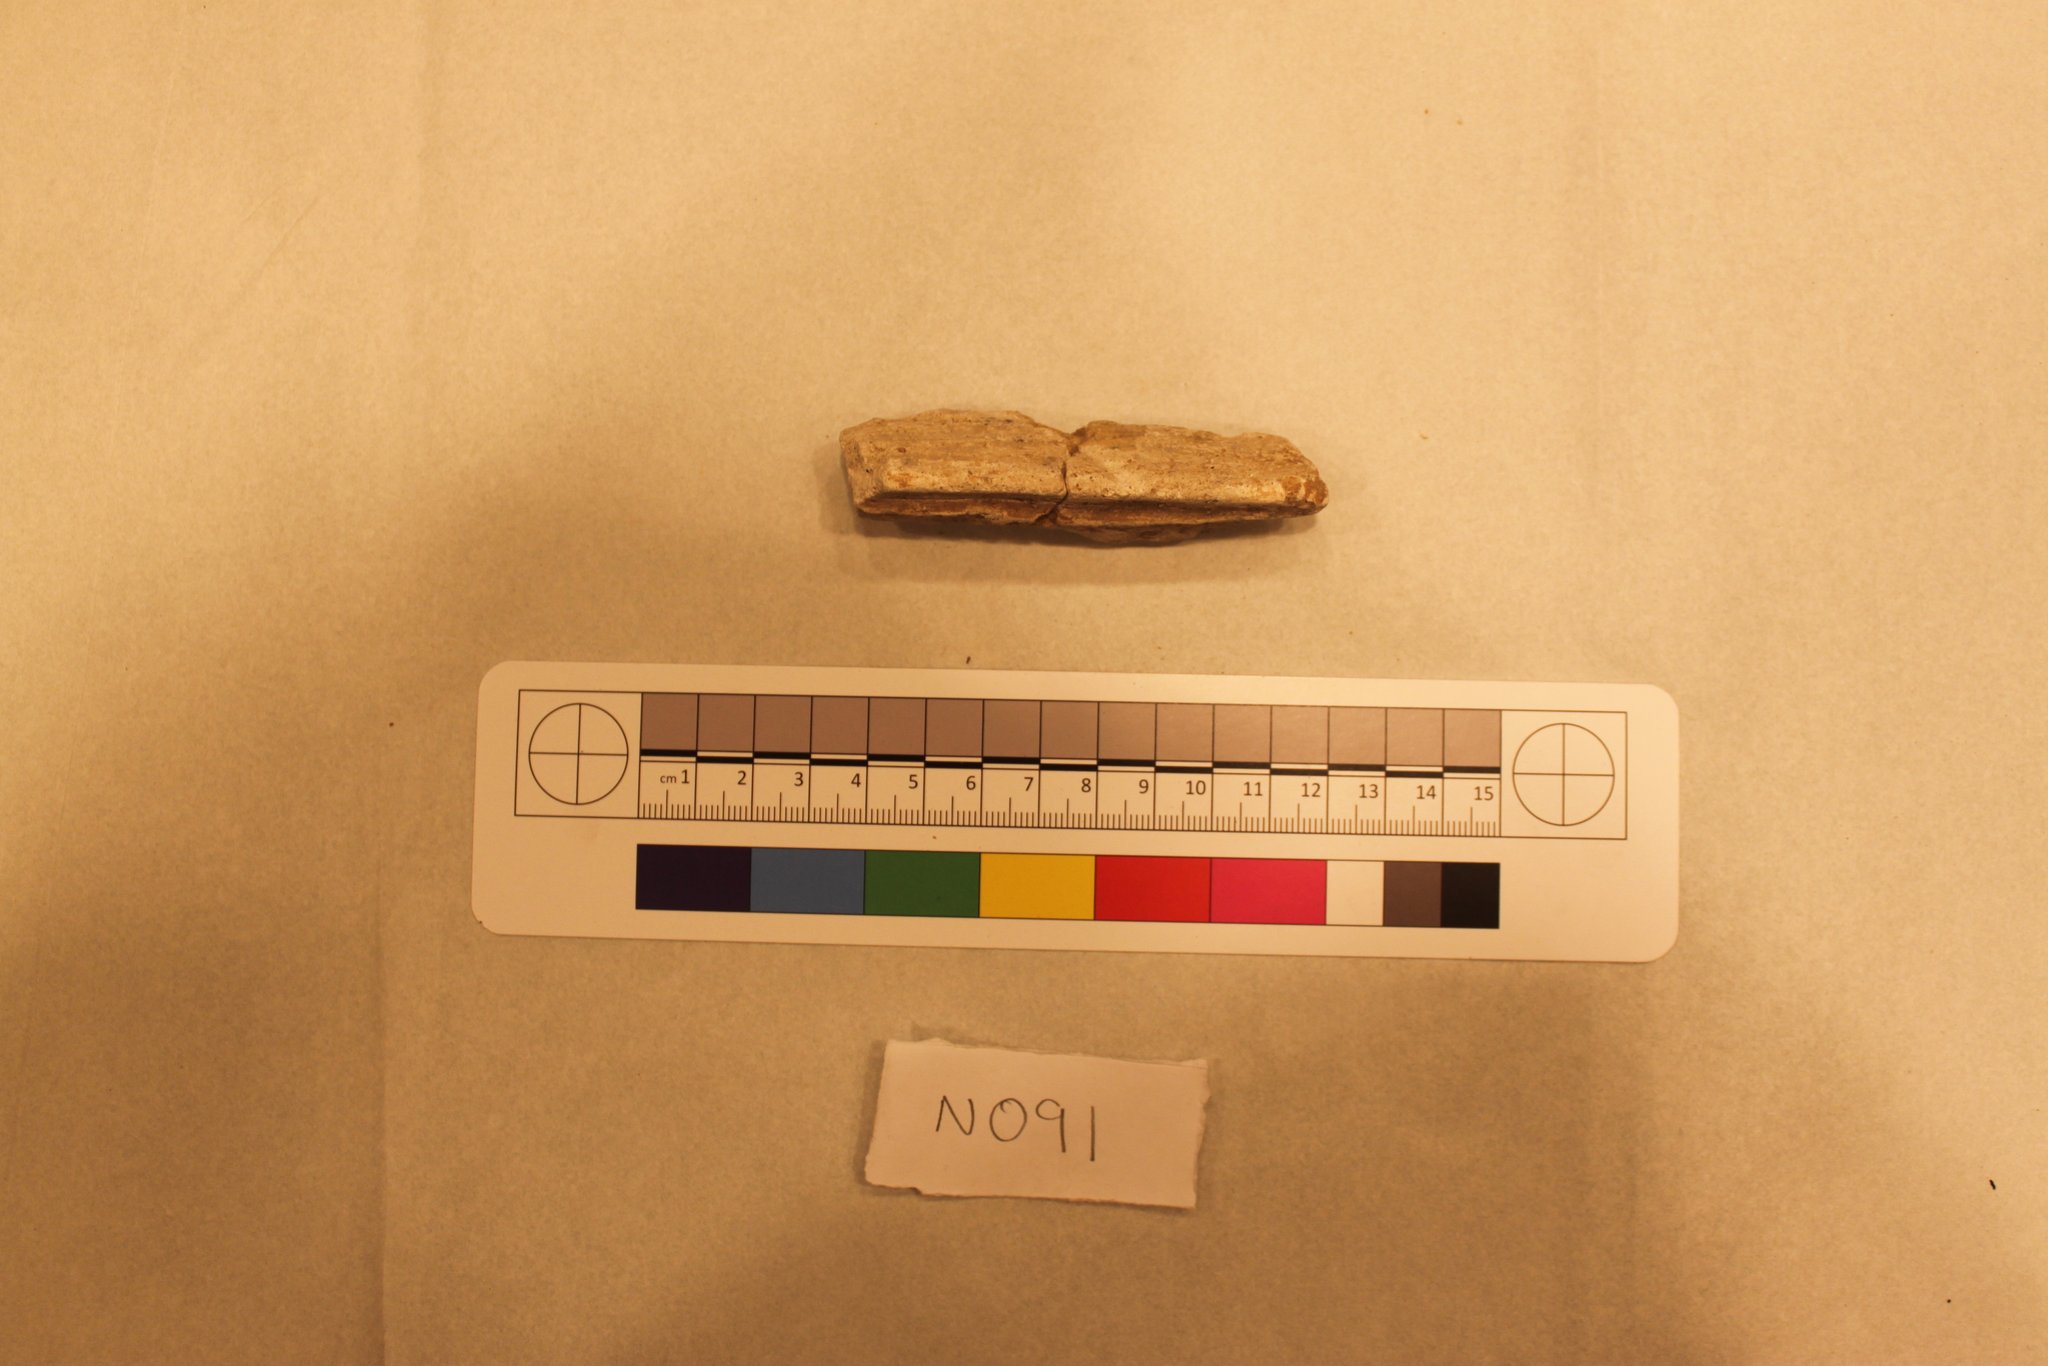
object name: fragment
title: Stucco Fragment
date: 701-1200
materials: plaster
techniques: carving, painting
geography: iran